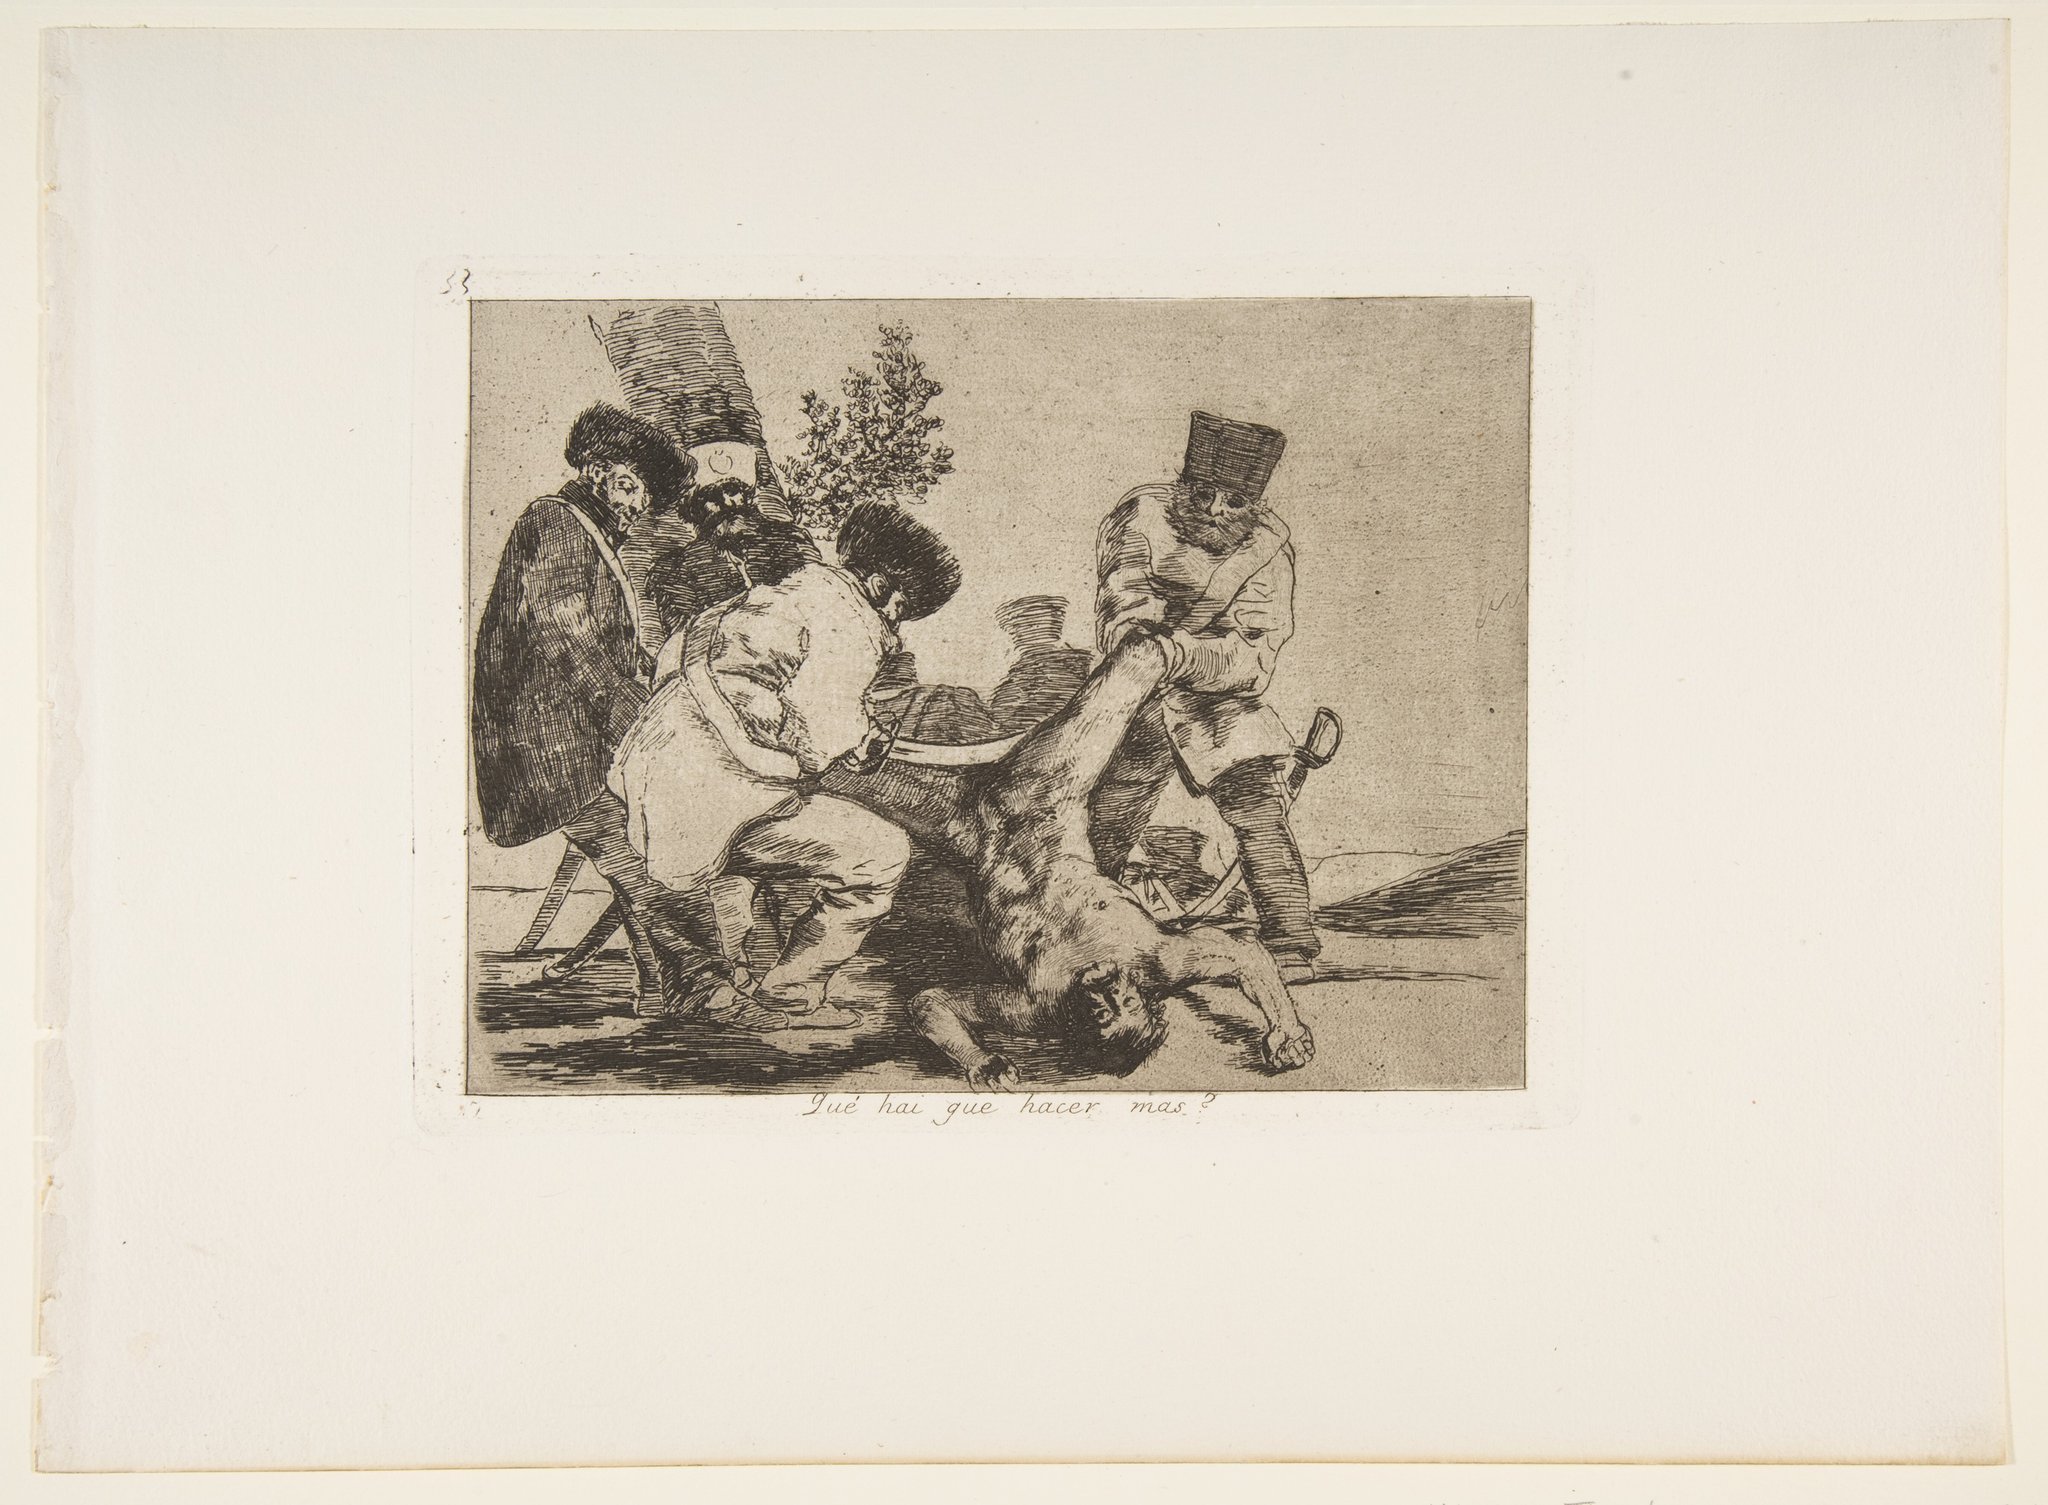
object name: print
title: Plate 33 from "The Disasters of War" (Los Desastres de La Guerra): 'What more can be done?' (Qué hai que hacer mas?)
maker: goya (francisco de goya y lucientes)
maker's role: artist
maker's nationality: spanish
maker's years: 1746-1828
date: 1810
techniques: engraving, drypoint, etching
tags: men,male nudes,trees